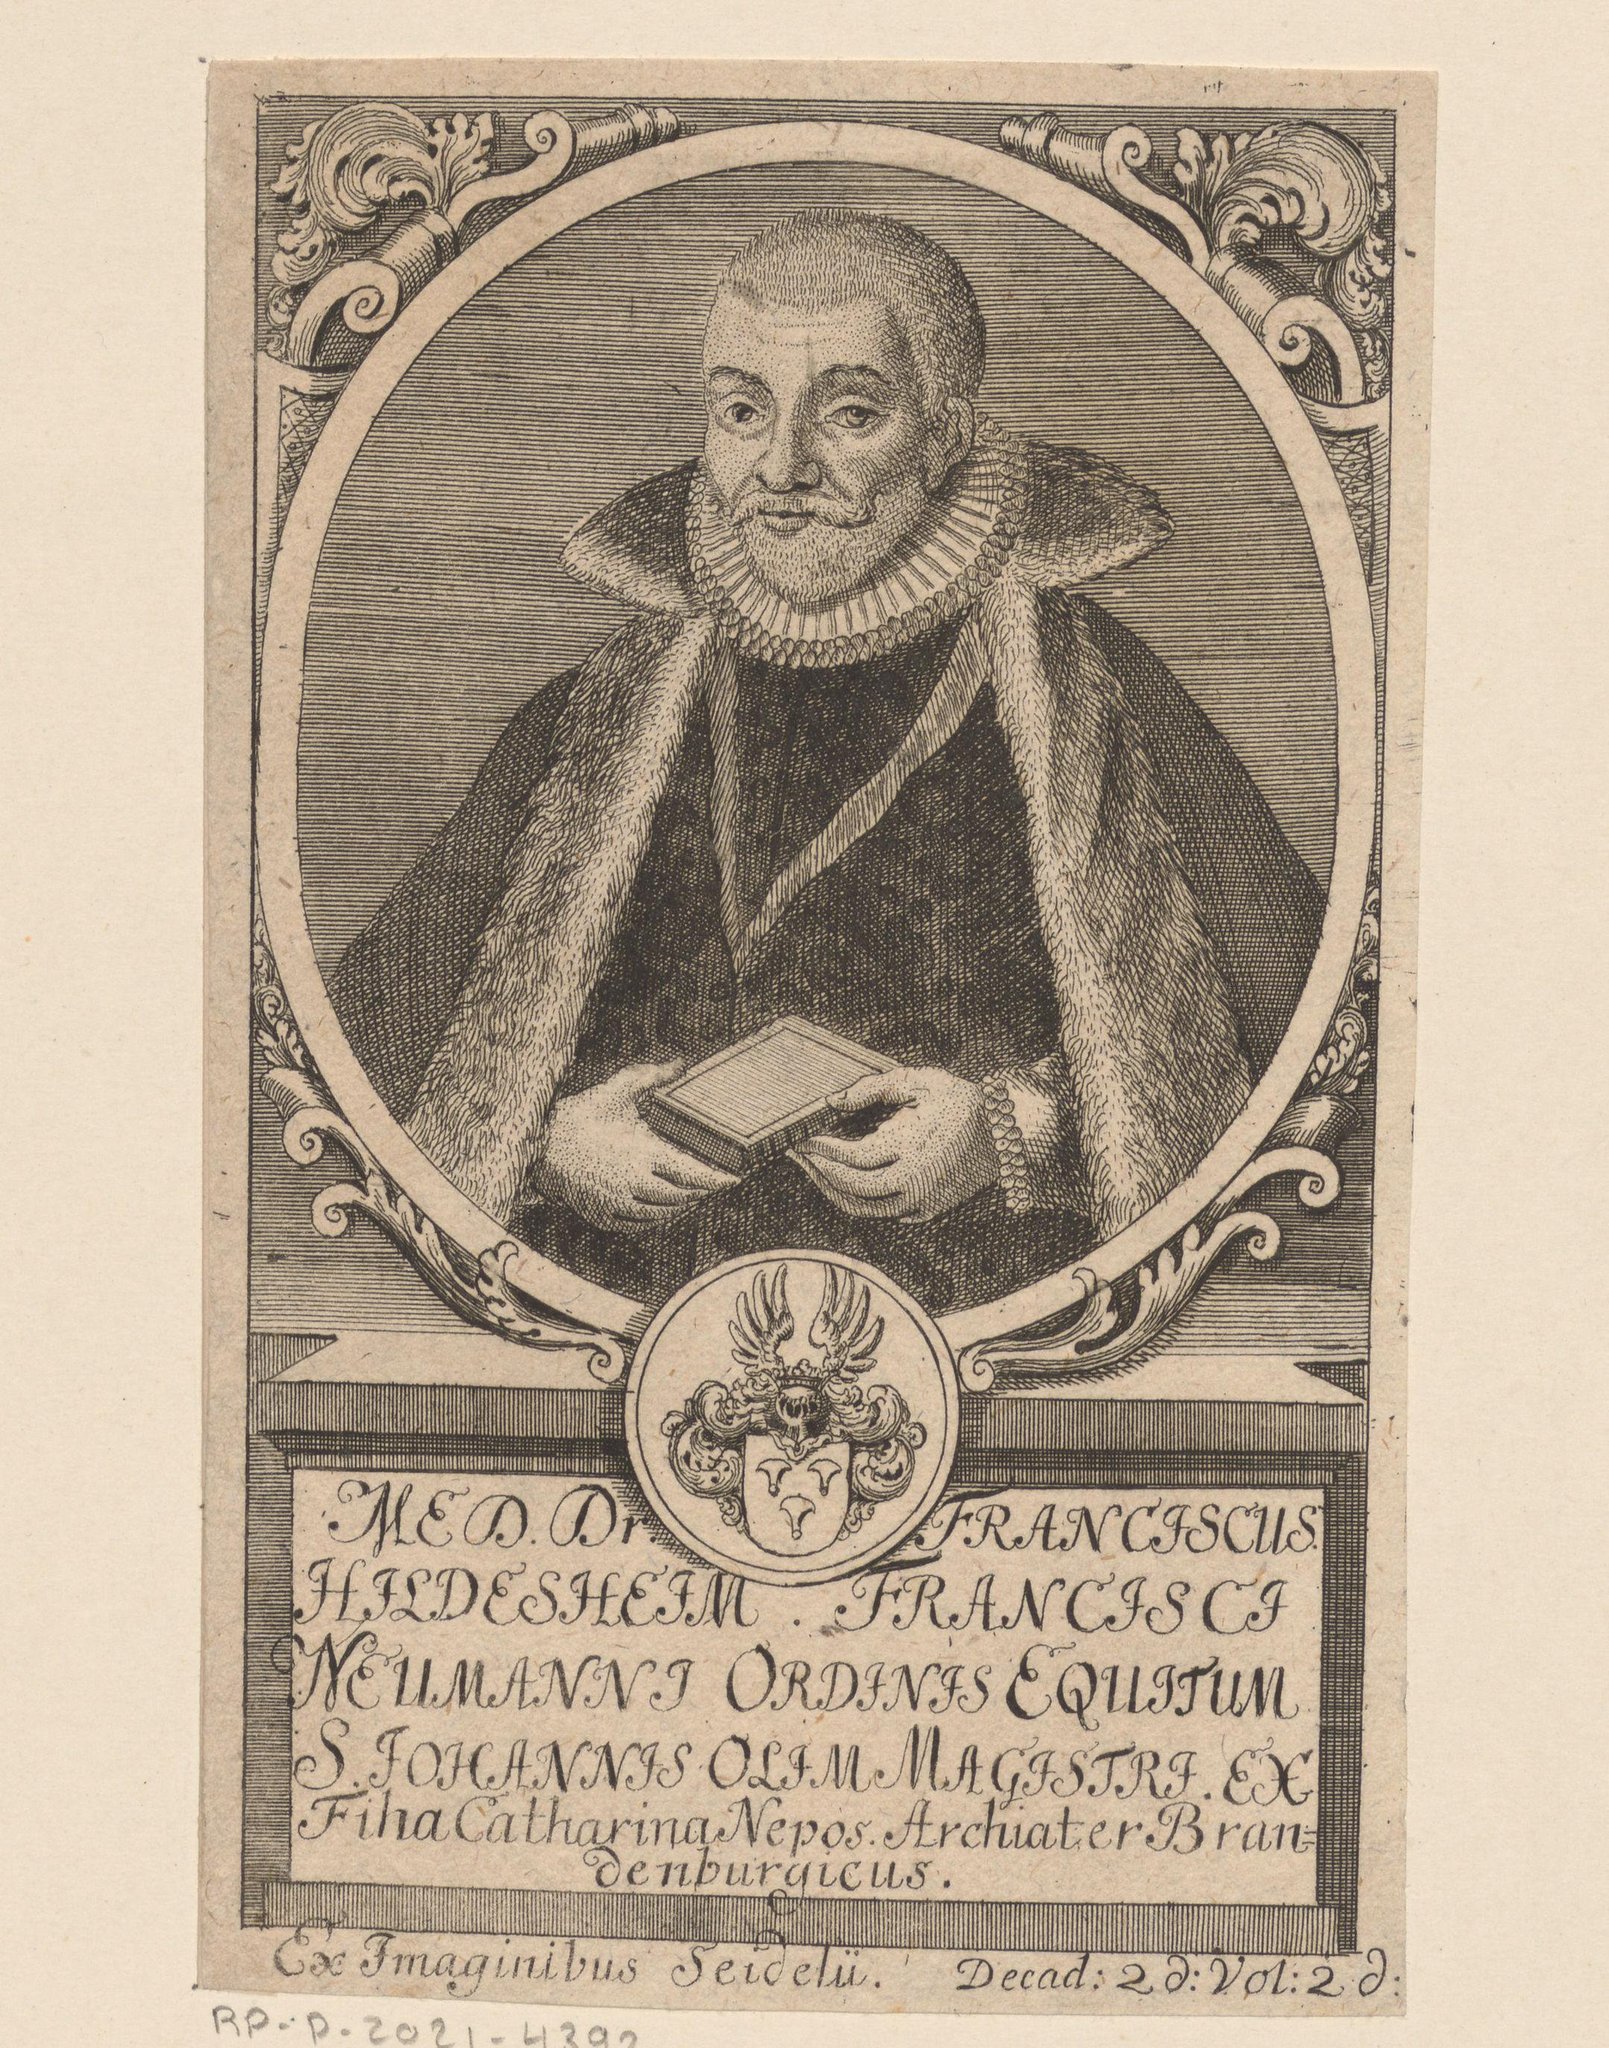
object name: book illustration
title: Portret van Franz Hildesheim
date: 1723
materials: paper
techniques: etching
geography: berlin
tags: berlin, historical persons, physician, doctor, book, armorial bearing, heraldry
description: Prent uit: Actorum medicorum Berolinensium (...). Berlijn: Gottfried Gedicke, 1723, dl. 2.